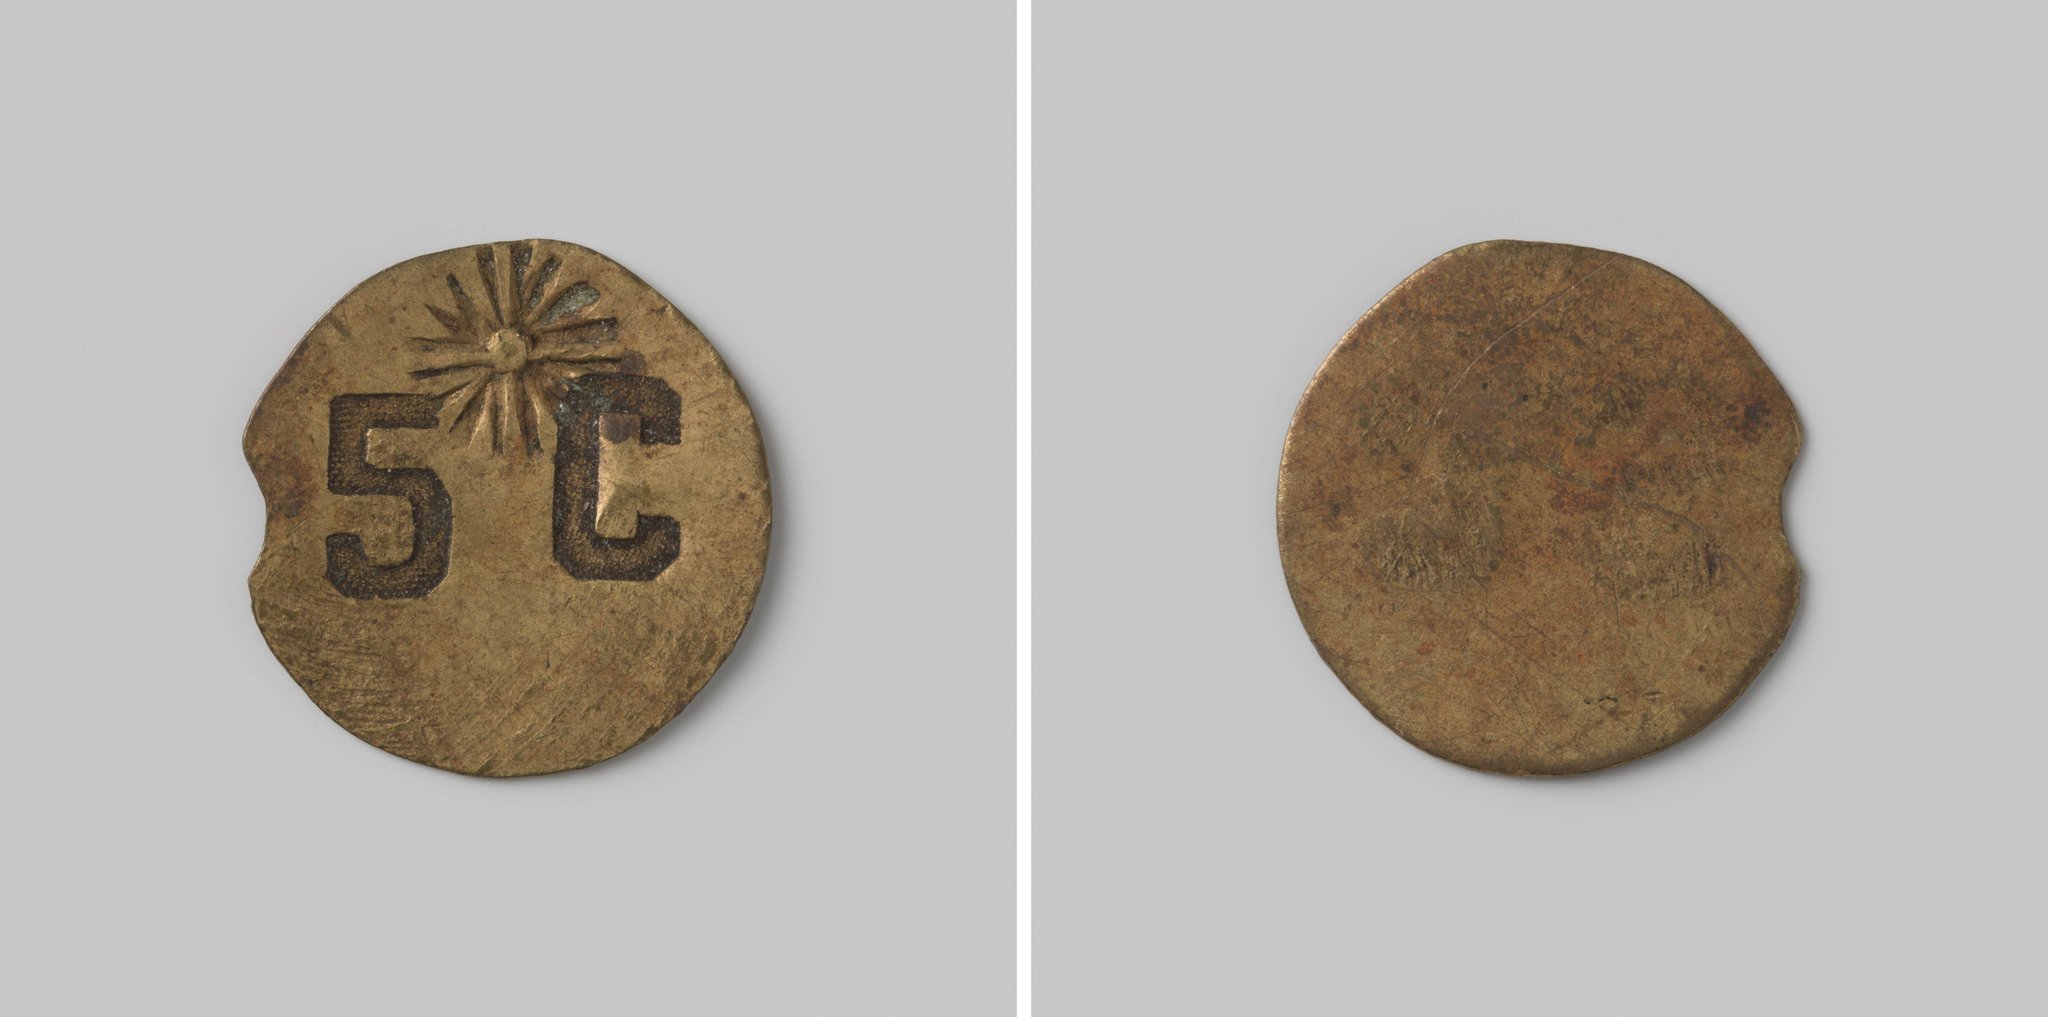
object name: history medal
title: Betaalpenning van 5 cents van de Coöperatieve Winkelvereeniging Eendracht Maakt Magt te Hilversum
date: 1875-1900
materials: brass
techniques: printing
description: Rond messing plaatje met randuitsparing met inwaartse instempelingen (ster) / 5 C